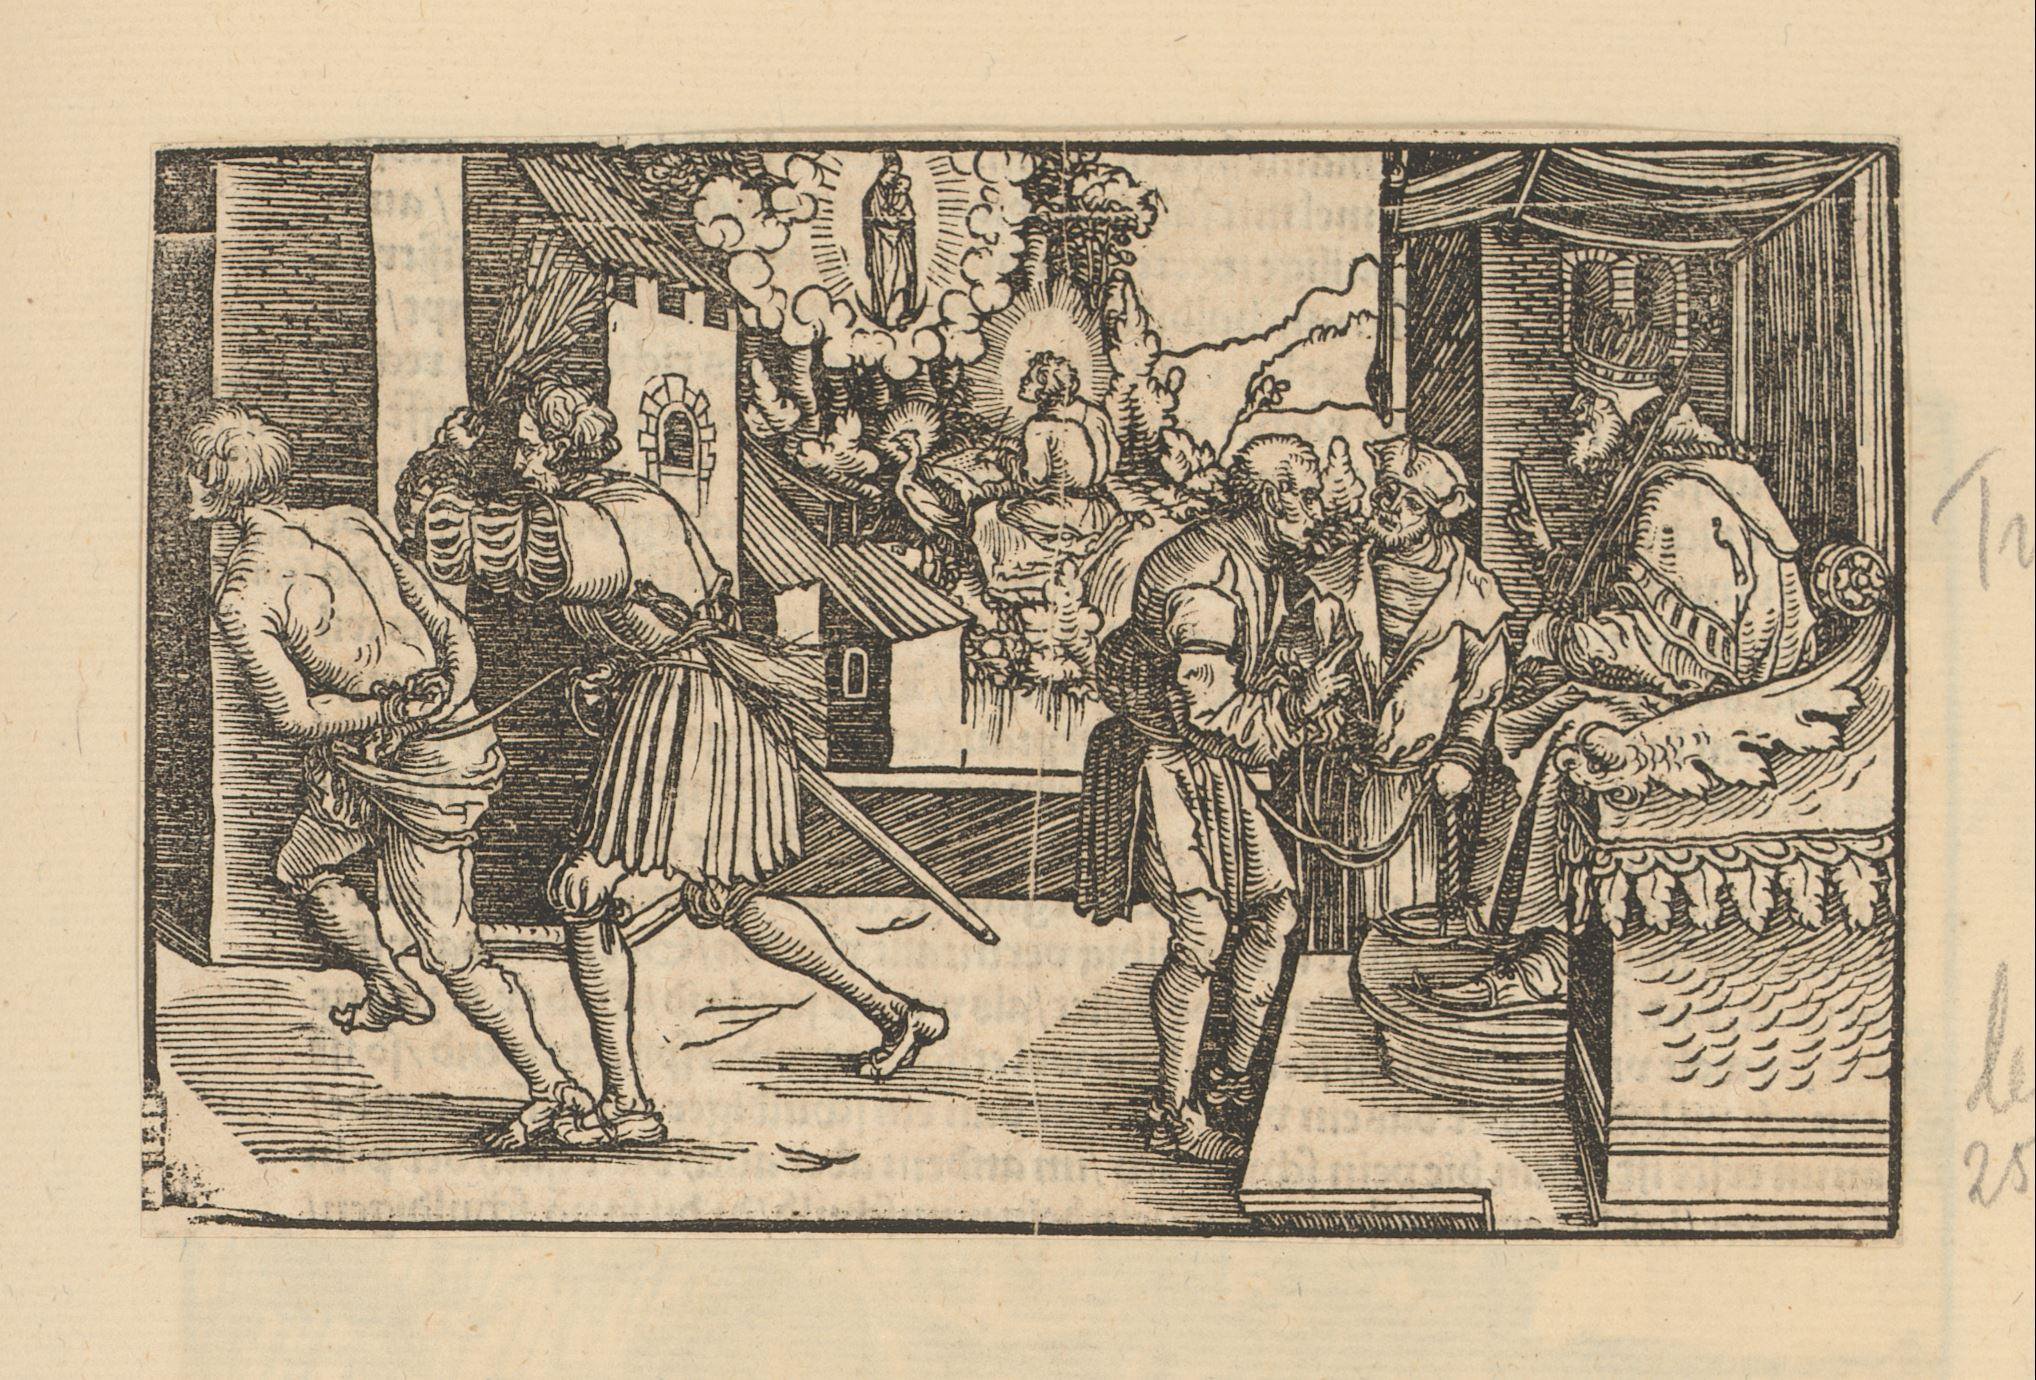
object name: print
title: Berechting, geseling en Johannes de Evangelist op Patmos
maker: Anonymous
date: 1514-1532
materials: paper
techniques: letterpress printing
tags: john (writing) on the island of patmos, possibly the eagle beside him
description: Deze prent is gebruikt in: Petrarca, Francesco. Von der Artzney bayder Glück, des guten und widerwertigen: unnd weß sich ain yeder inn Gelück und Unglück halten sol (...). Augsburg: Heinrich Steiner, 1532. Deze uitgave is ook bekend onder de titel 'Trostspiegel in Glück und Unglück'.